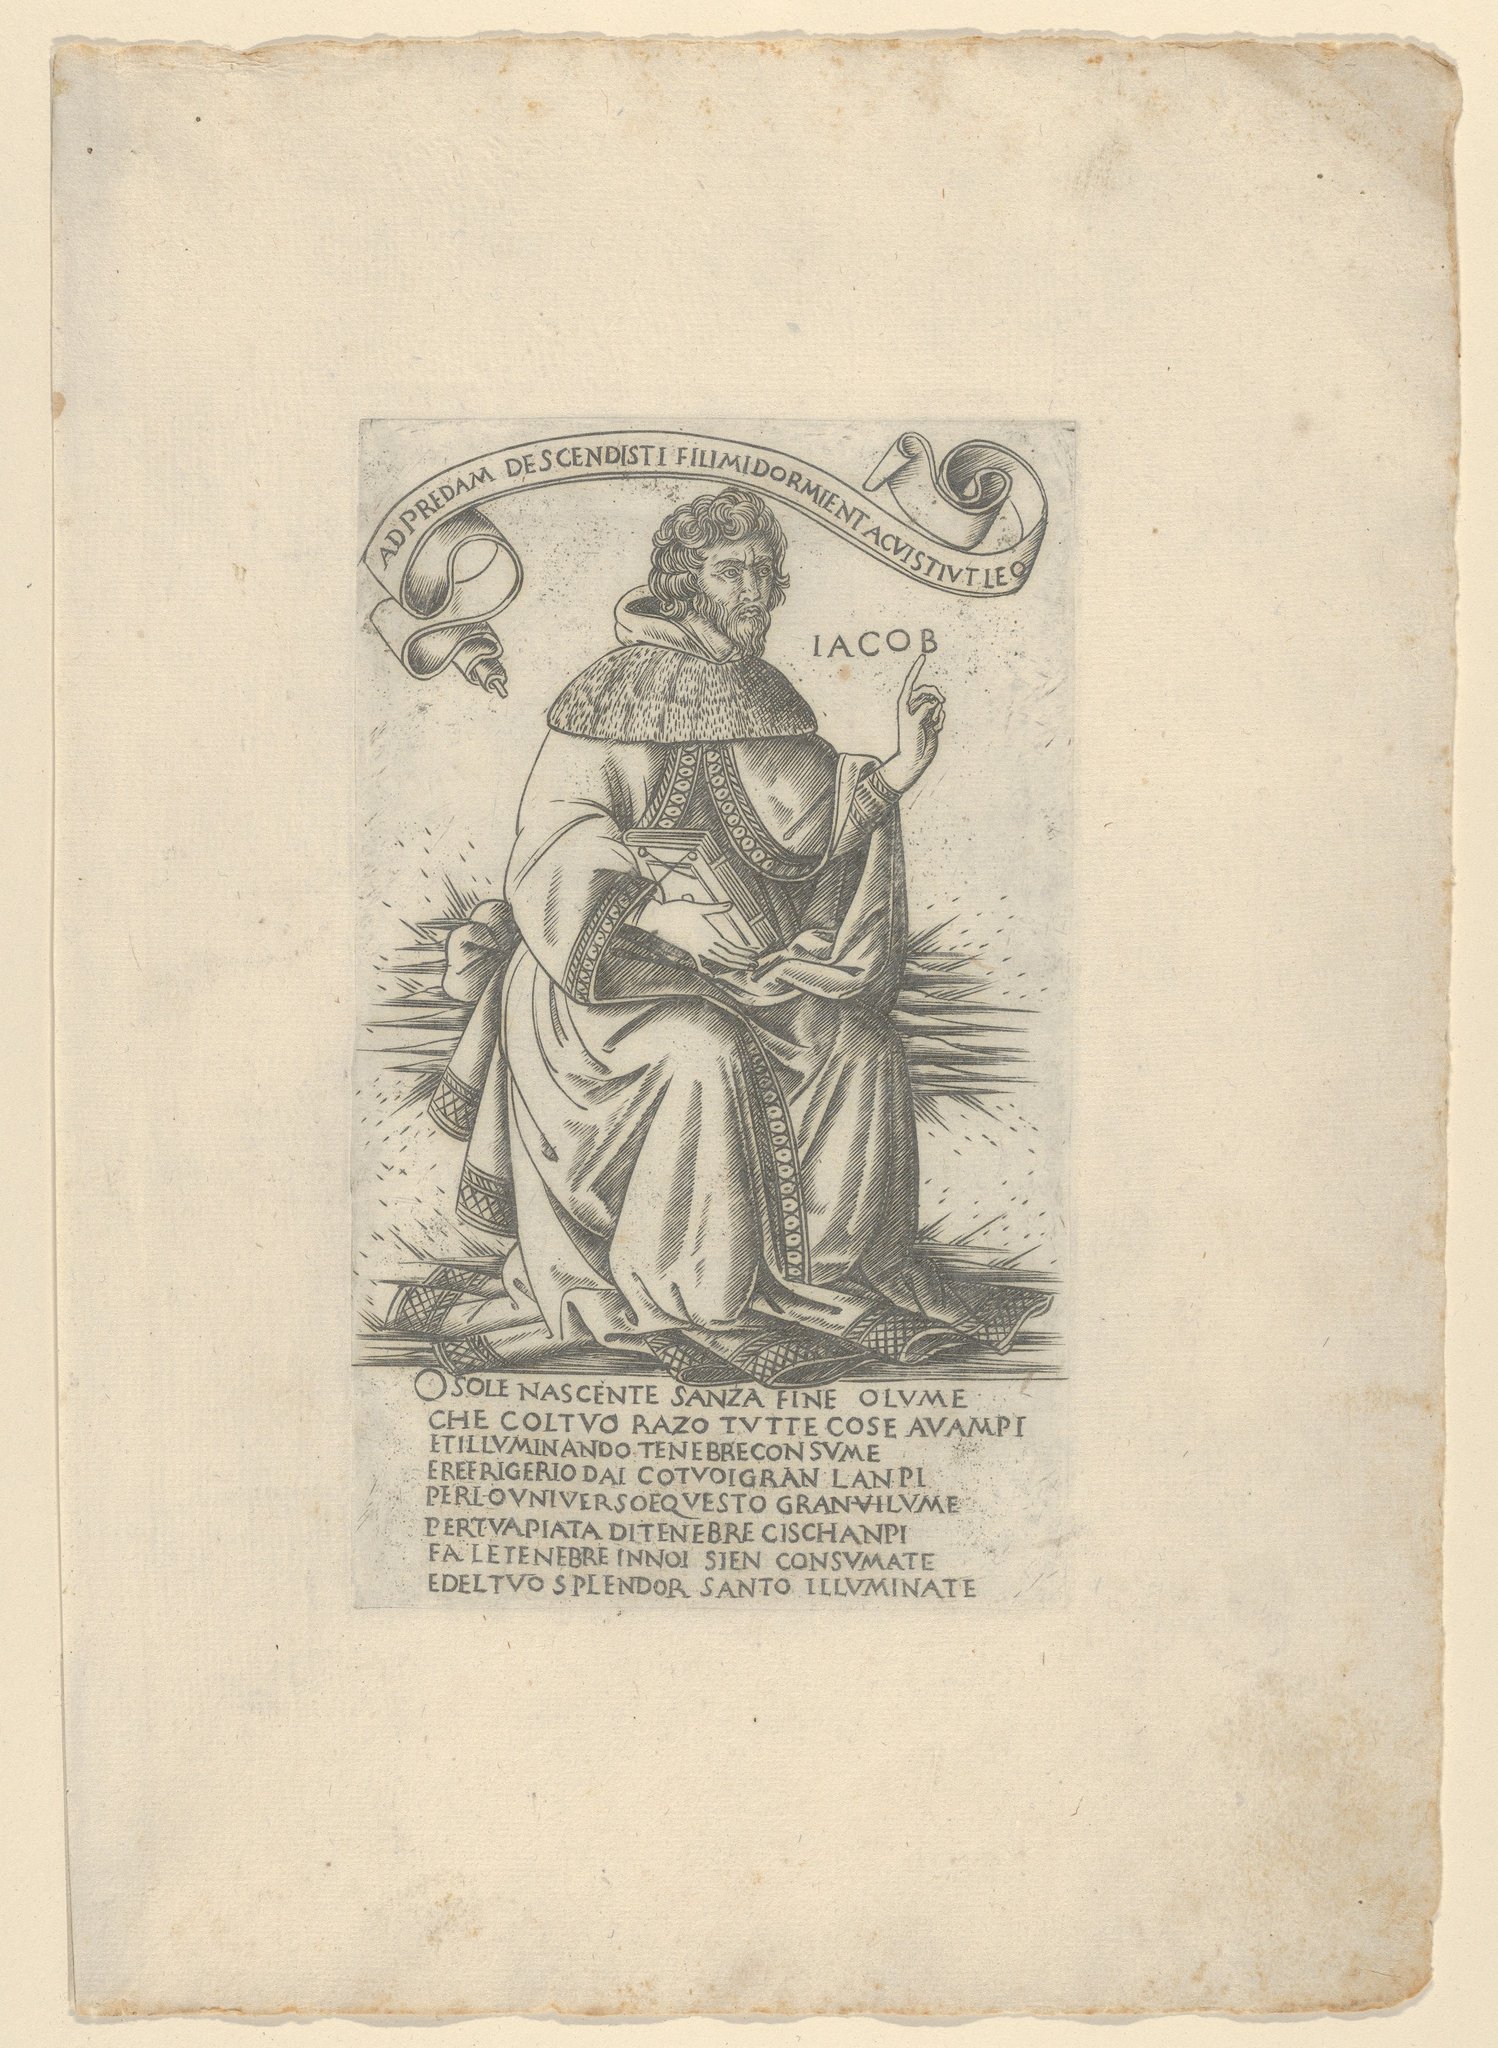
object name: print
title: The Prophet Jacob, from "Prophets and Sibyls"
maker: francesco rosselli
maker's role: artist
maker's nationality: italian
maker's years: 1448-1527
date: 1480-1490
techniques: engraving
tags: men